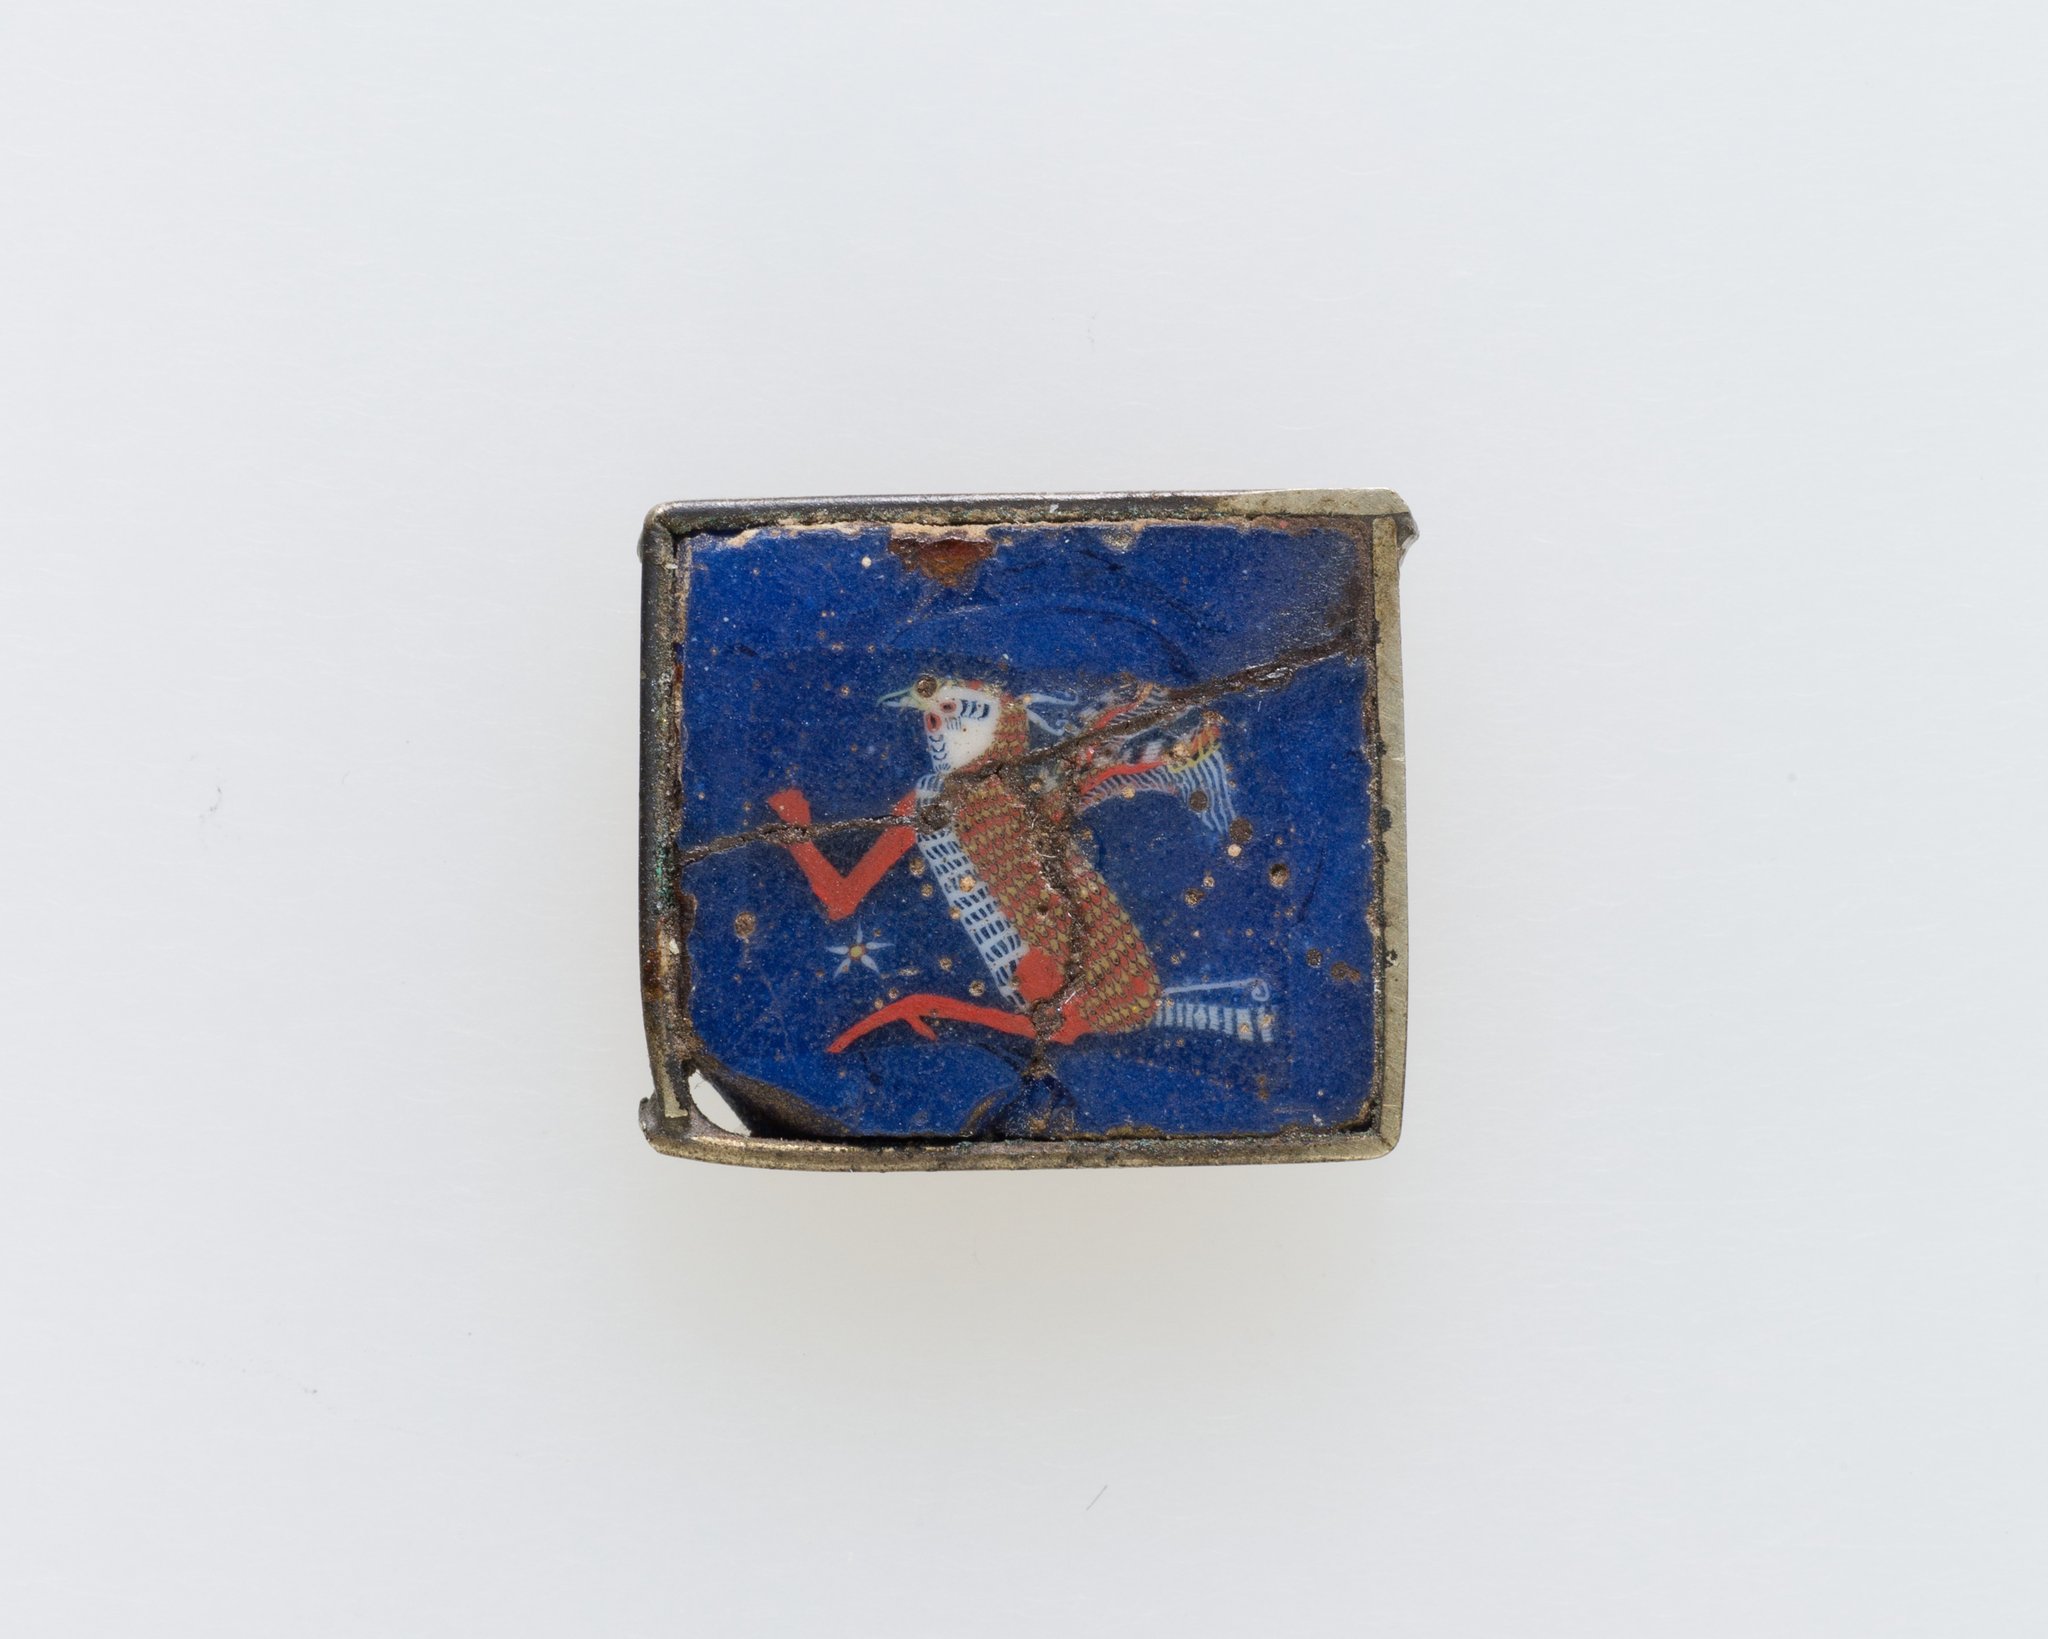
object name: inlay, rekhyt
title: Inlay, rekhyt bird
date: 100 BCE-100 CE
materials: glass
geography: egypt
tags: birds